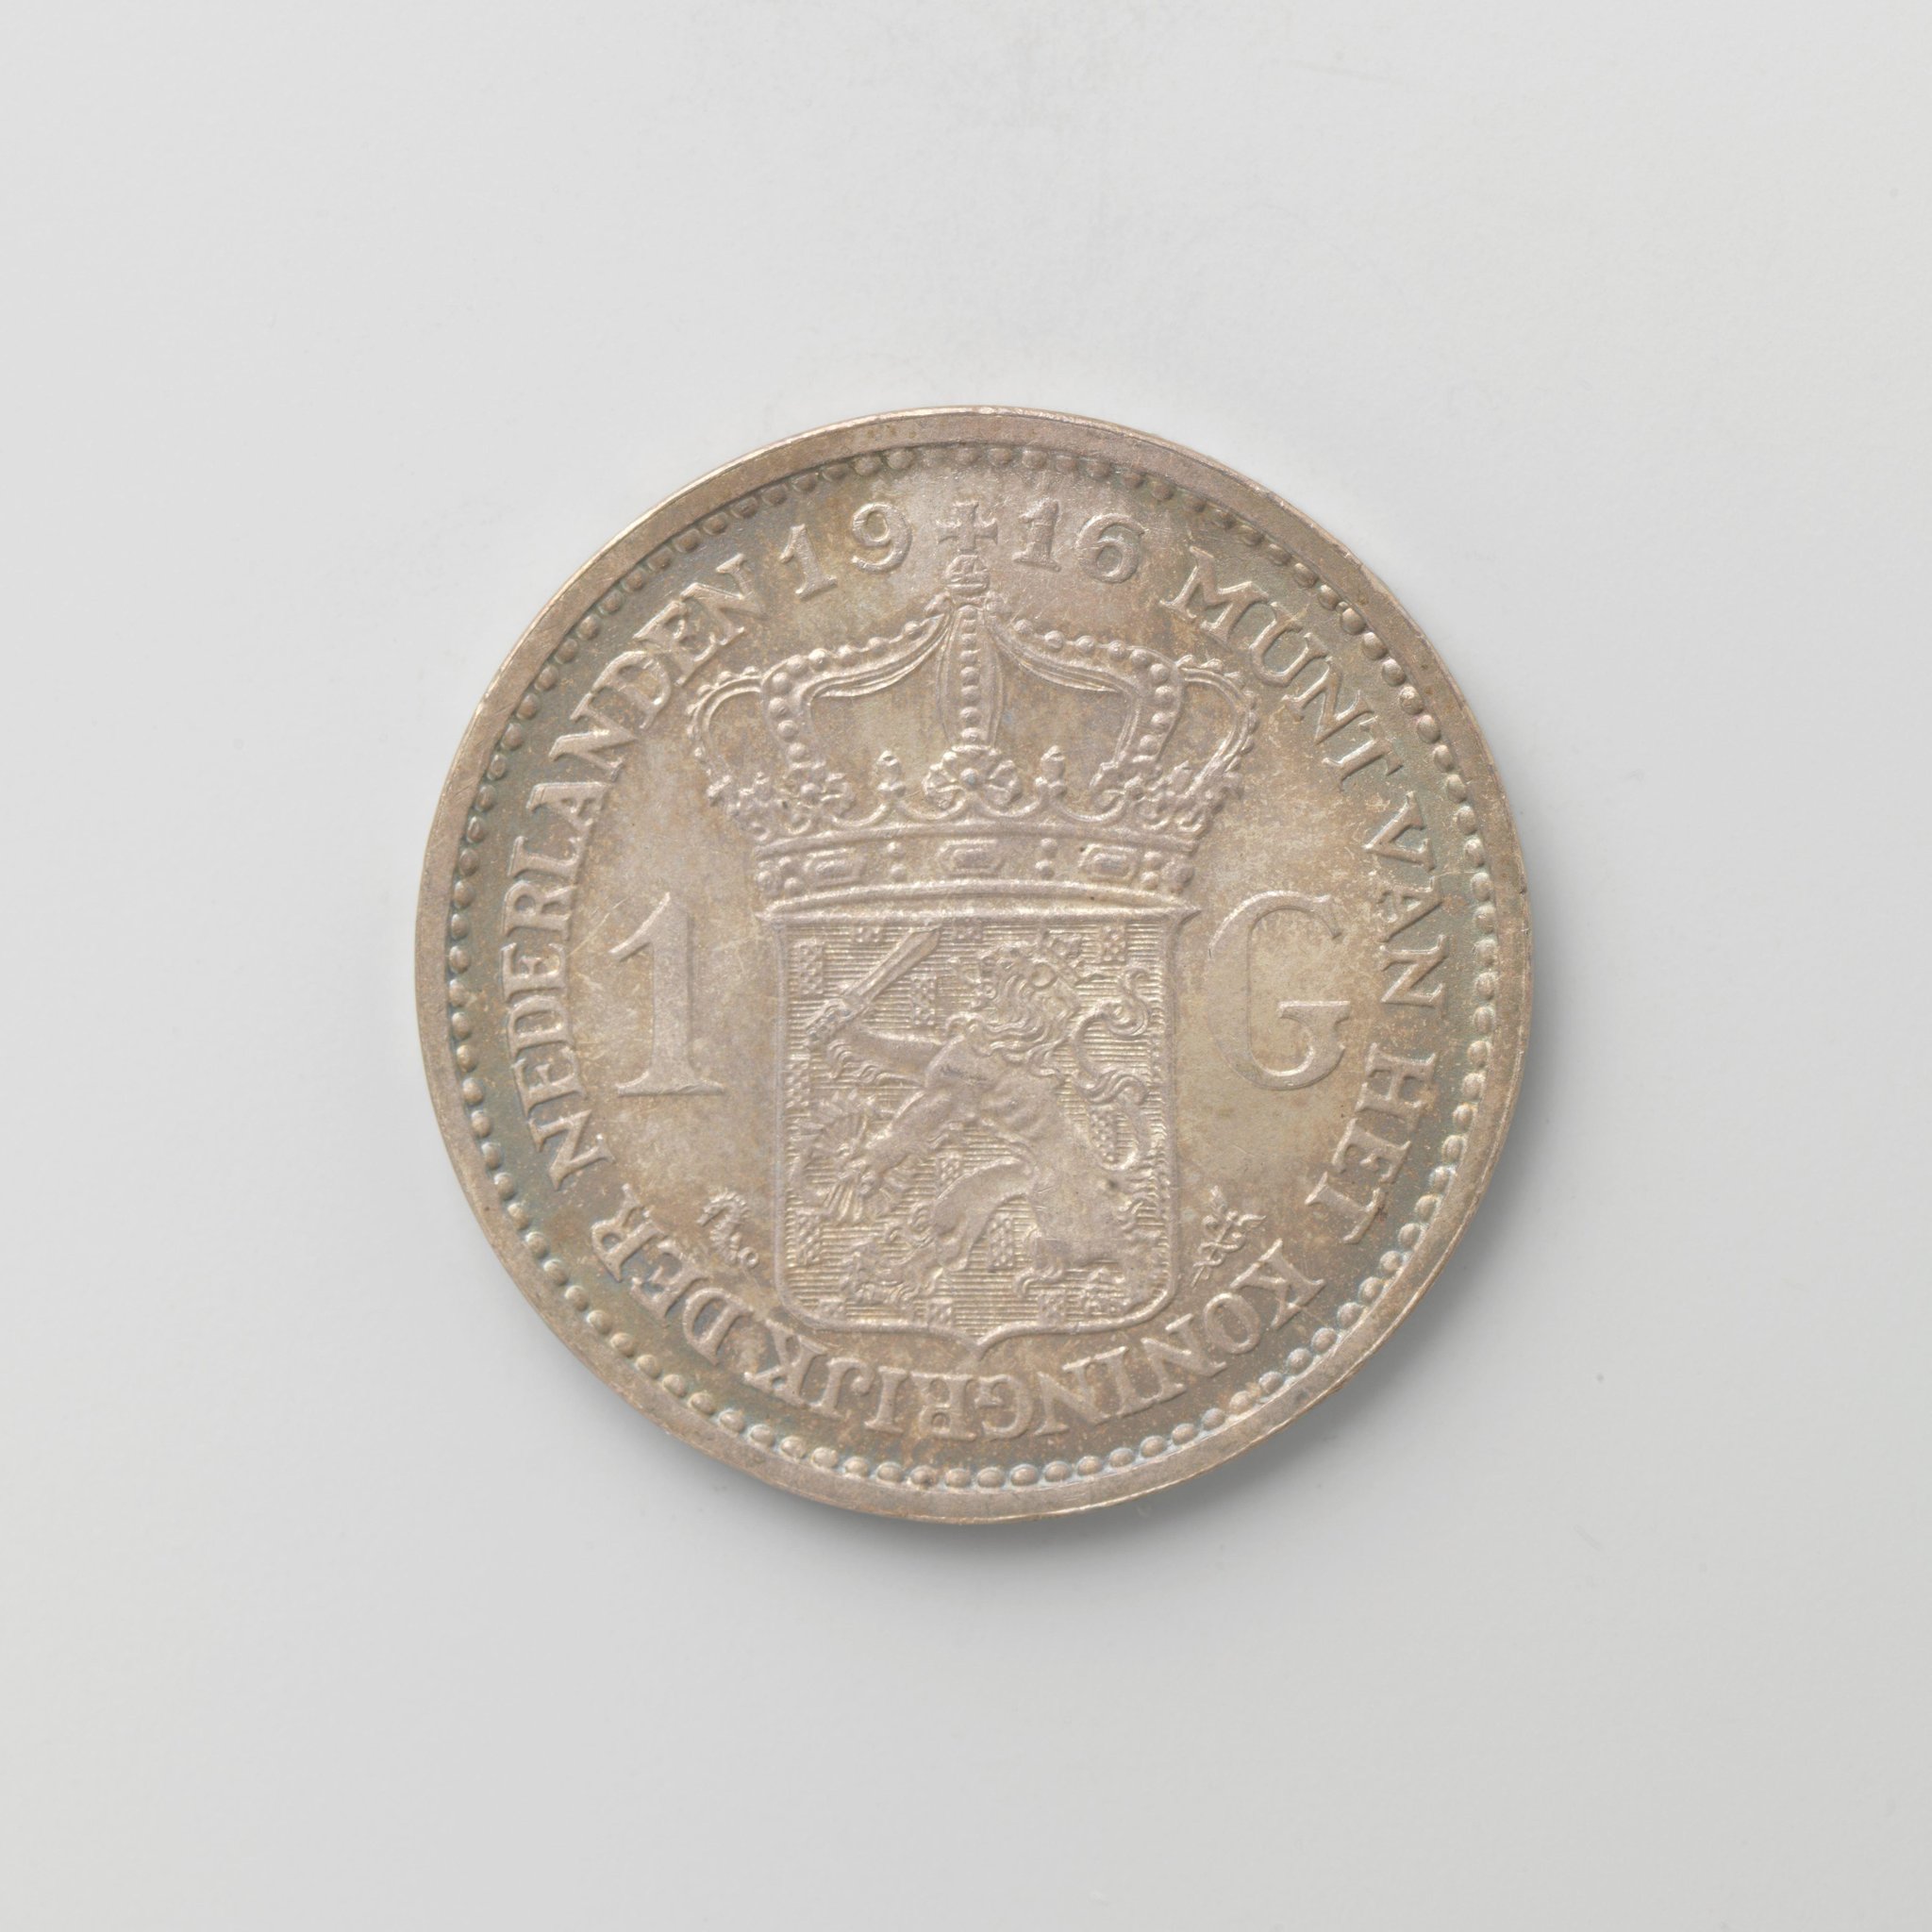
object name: coin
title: Nederland, gulden,1916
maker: wilhelmina of the netherlands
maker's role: print maker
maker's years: 1880-1962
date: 1916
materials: silver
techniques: striking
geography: utrecht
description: Zilveren munt. Voorzijde: gedrapeerd borstbeeld met diadeem naar links.Keerzijde: tussen waarde-aanduiding 1 G gekroond rijkswapenschild. Jaartal bovenaan in omschrift. Randschrift.